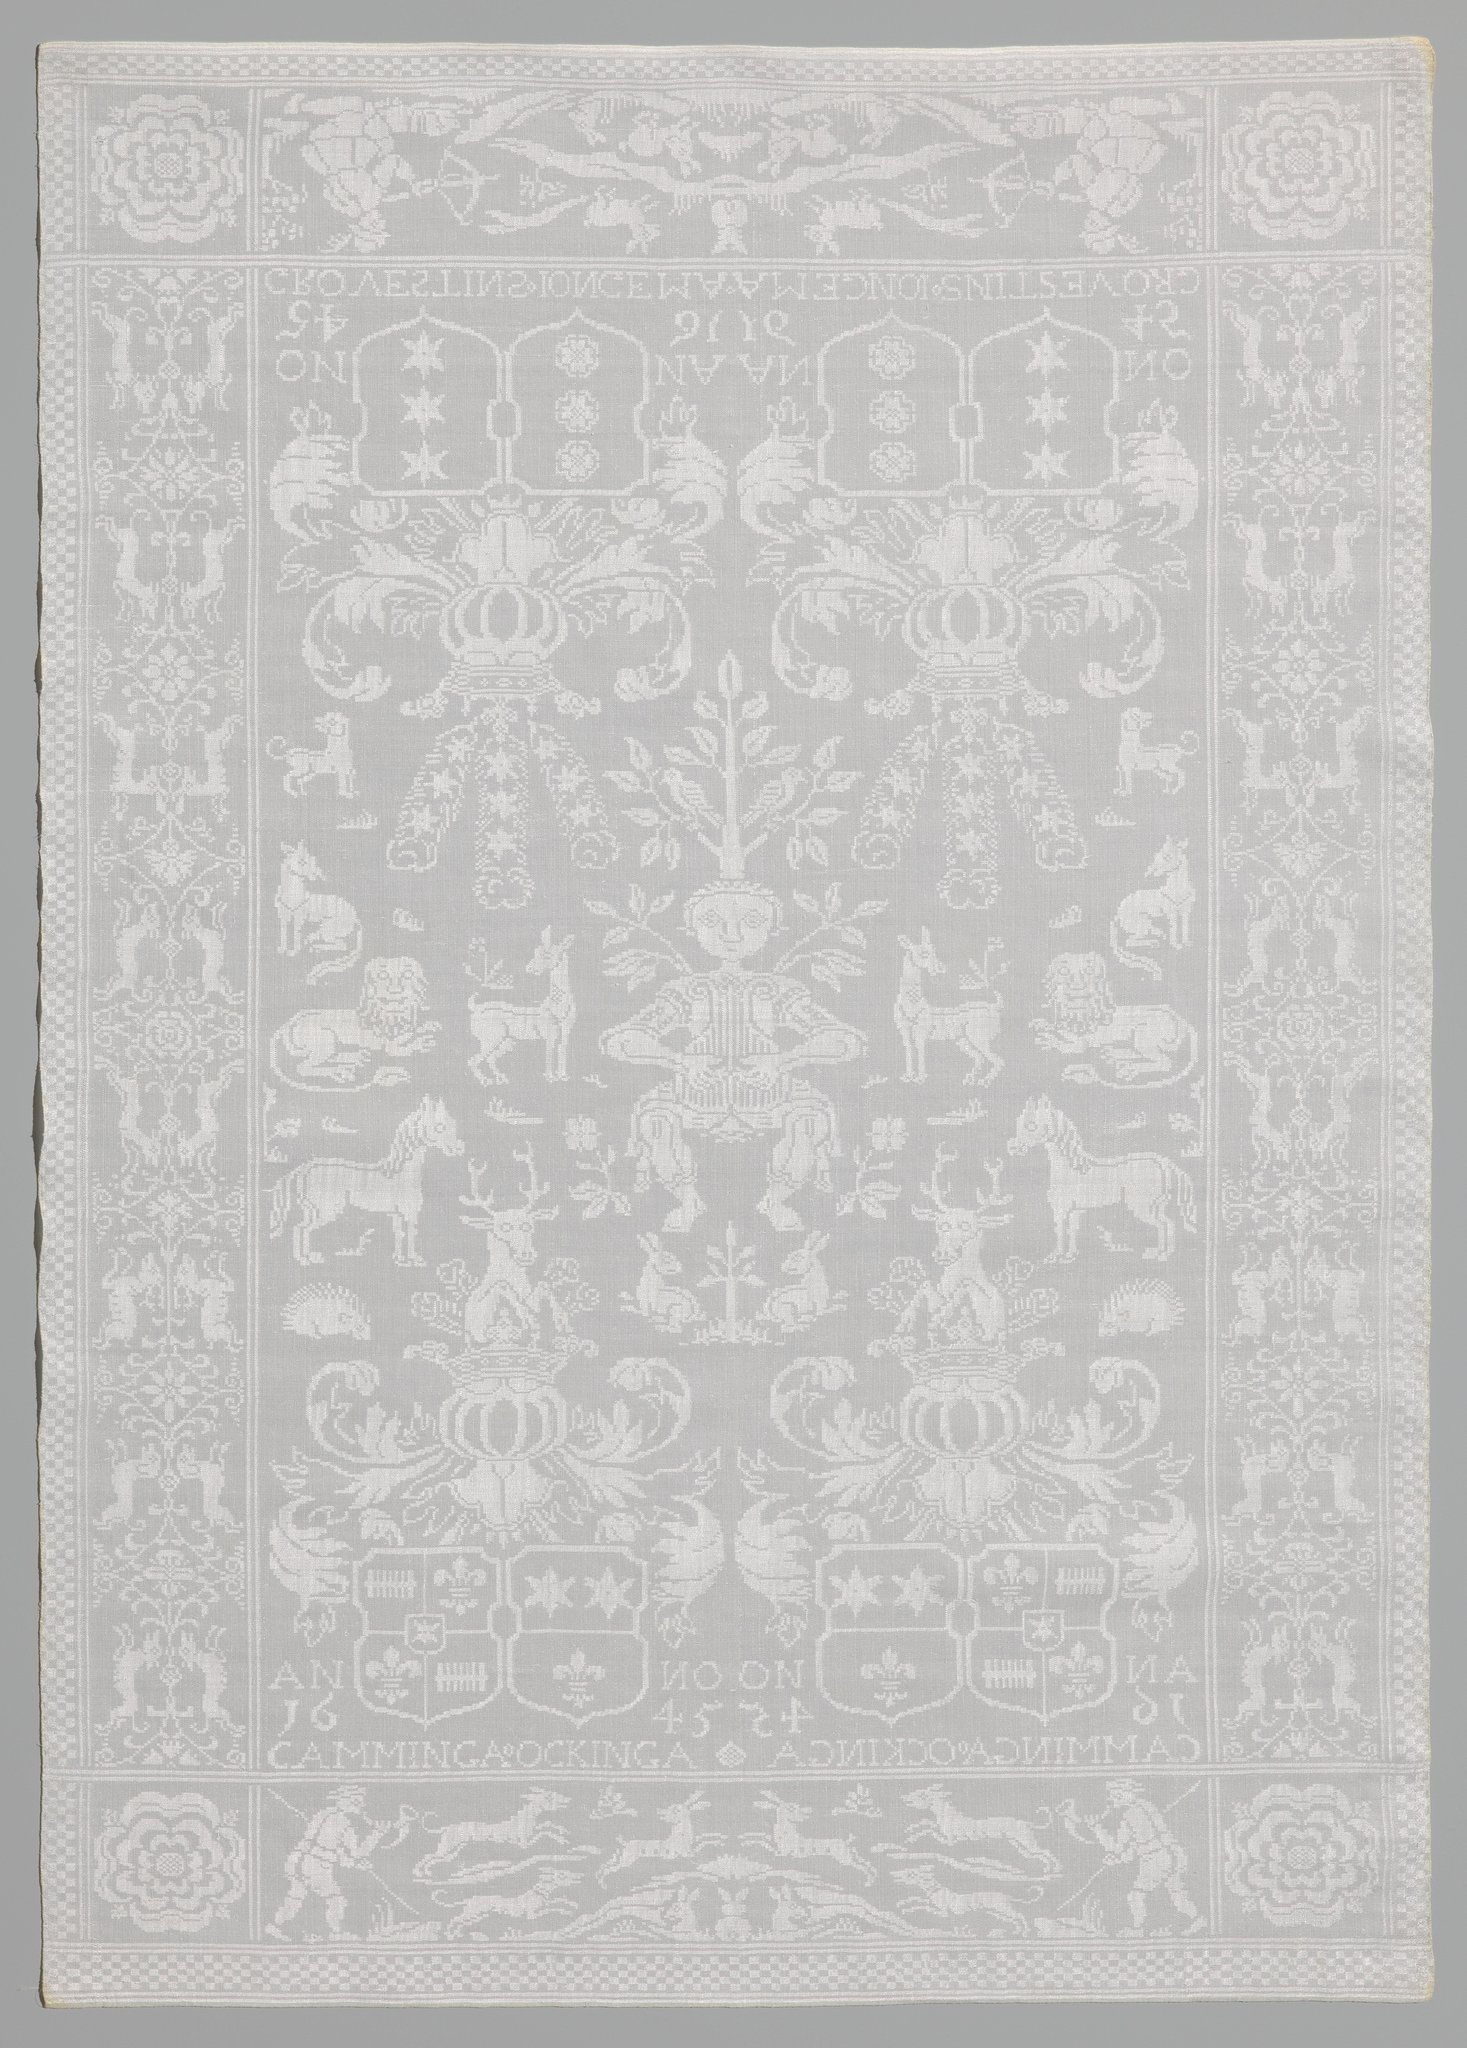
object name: napkin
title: Servet met Friese wapens en Orpheus te midden van de dieren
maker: quirijn jansz. damast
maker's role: mayor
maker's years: 1580-1638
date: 1645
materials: linen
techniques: damask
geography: haarlem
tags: orpheus playing the lyre: trees and rocks move, beasts and birds are enchanted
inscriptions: date